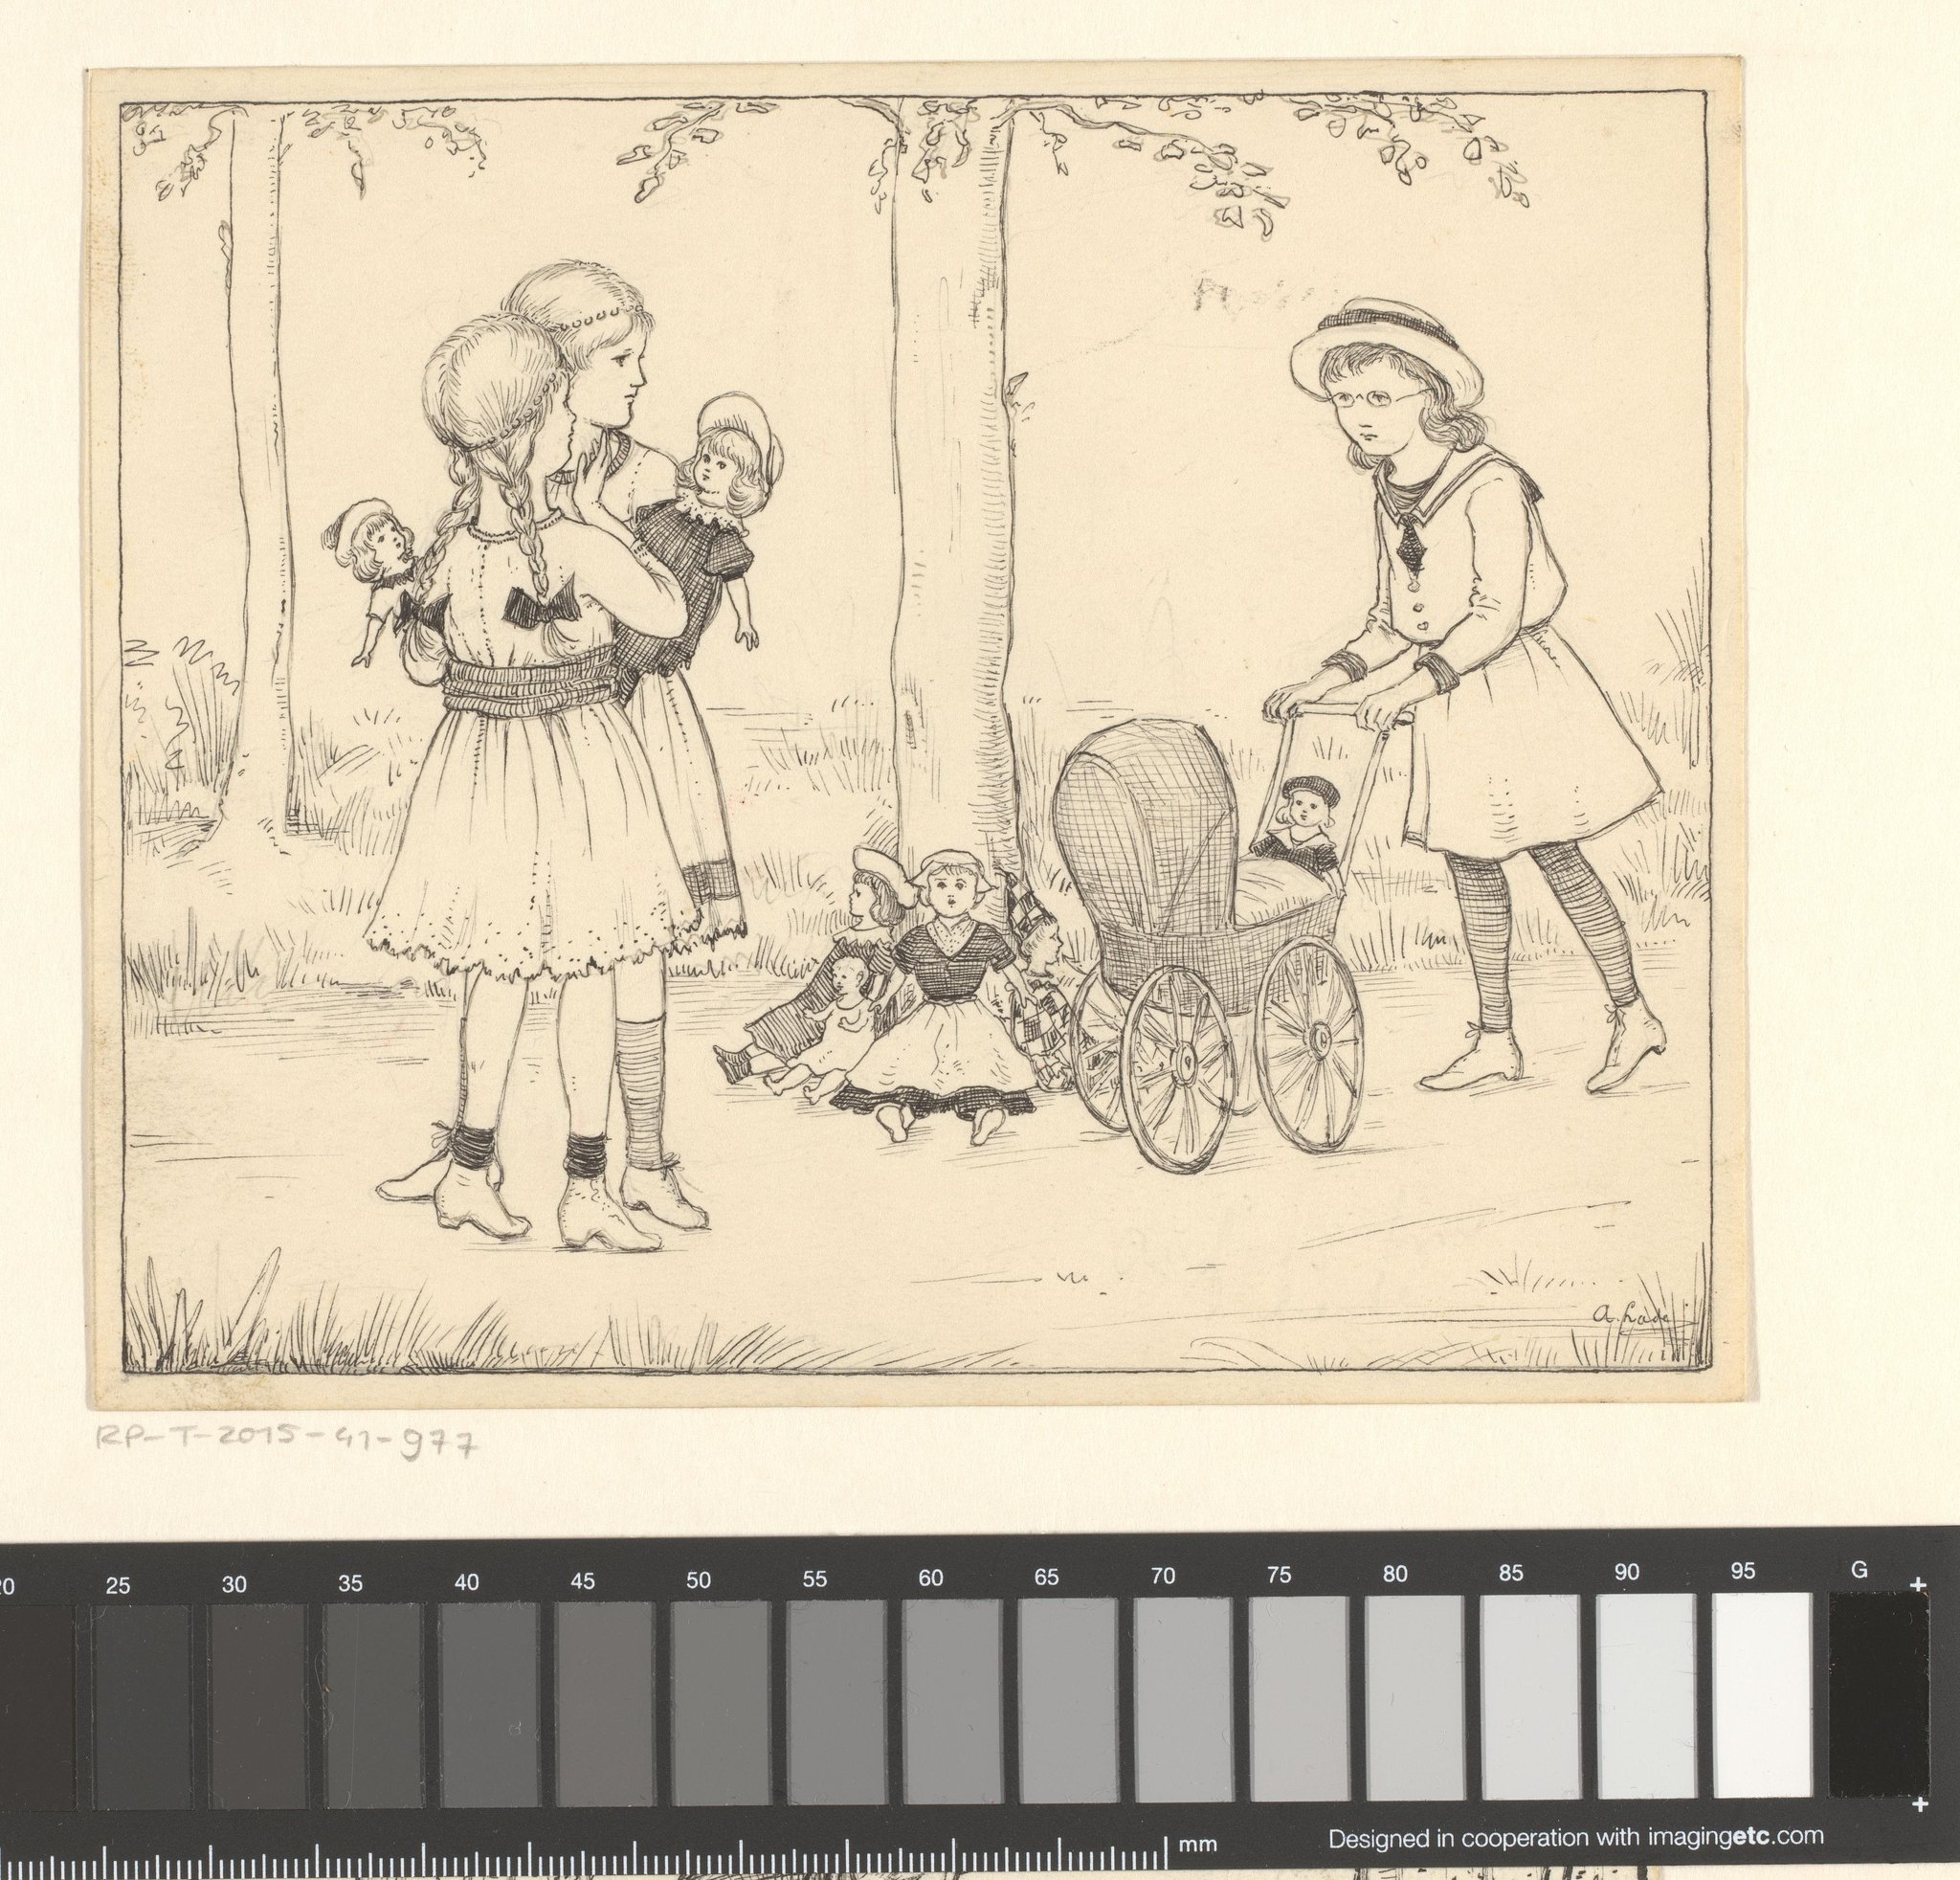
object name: boekillustratie ontwerp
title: Drie meisjes met poppen op een pad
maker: adri ladenius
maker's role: draughtsman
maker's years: 1883-1953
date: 1893-1953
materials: ink, paper, pencil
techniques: pen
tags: road, path, (playing with) dolls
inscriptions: signature: ‘A. Lade’, :, collector's mark: Lugt 2228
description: Twee meisjes staan met een pop op de arm op een pad. Een derde meisje komt aanlopen met een poppenwagen. Rond een boom zitten nog eens vier poppen.